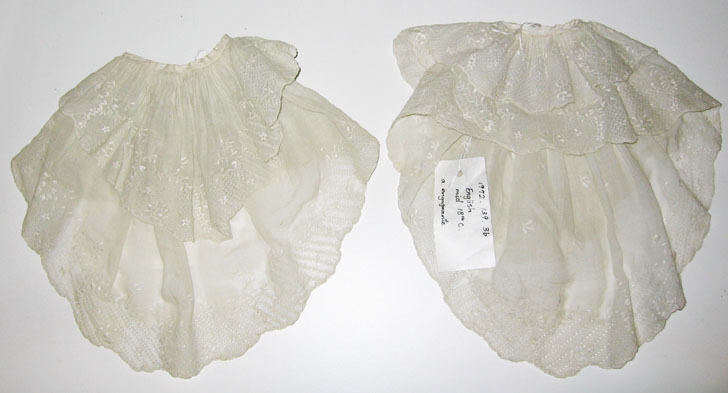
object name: engageantes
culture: british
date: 1701-1800